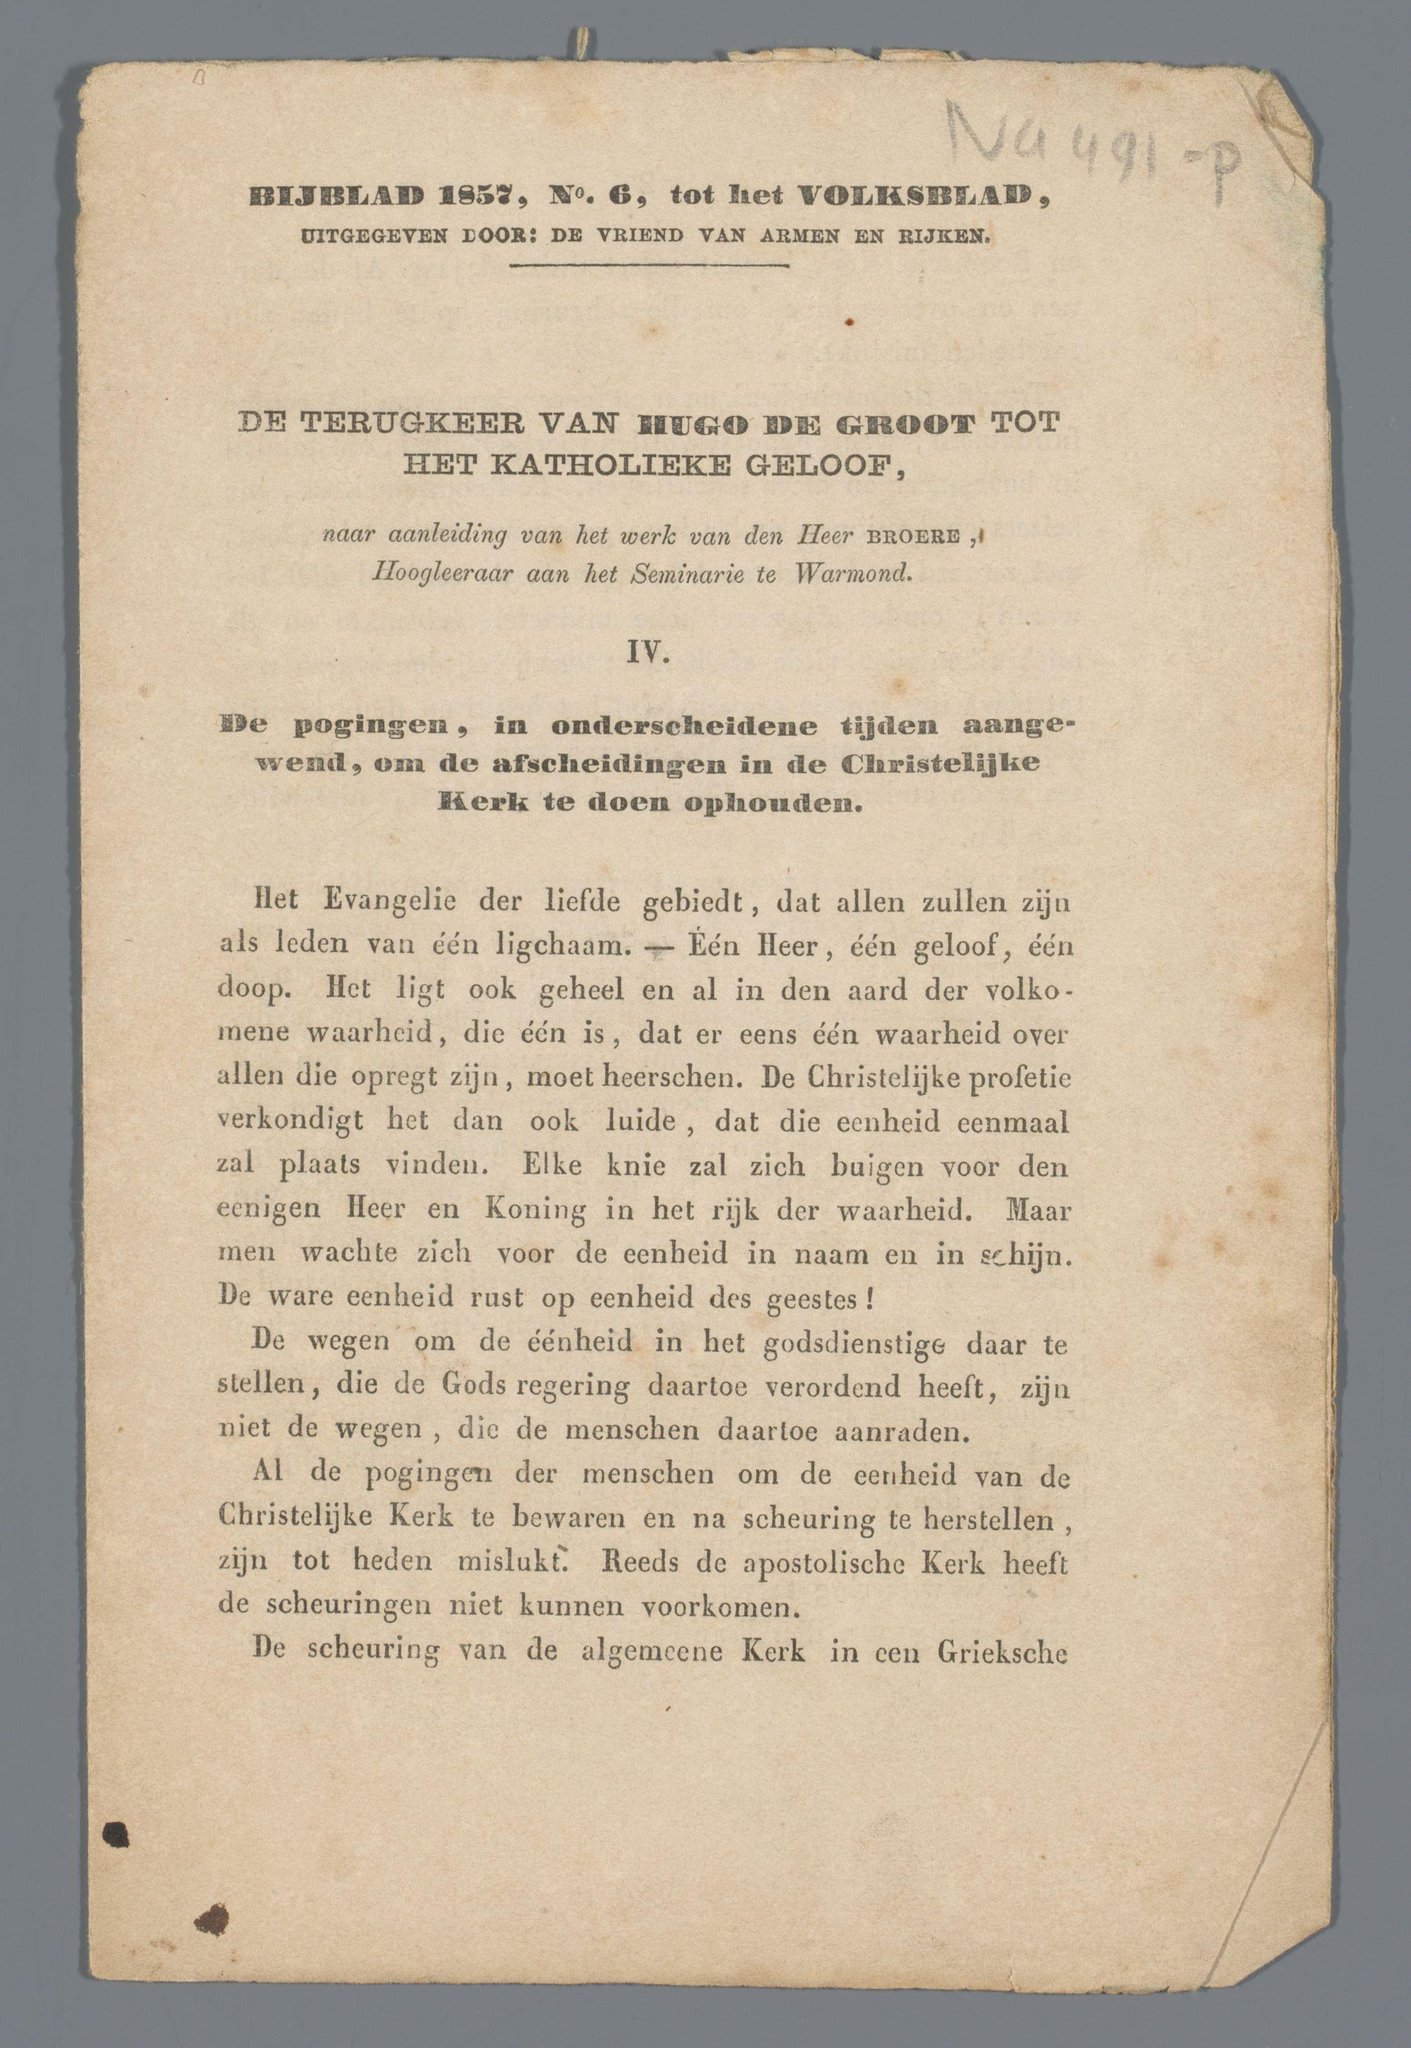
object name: brochure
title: De Terugkeer van Hugo de Groot tot het katholiek geloof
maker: e.s. witkamp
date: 1857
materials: paper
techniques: printing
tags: netherlands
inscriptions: date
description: Brochure, 12 pp, niet gebonden. Bij blad 1857, nr 6 van het Volksblad. Gedateerd; voorp.